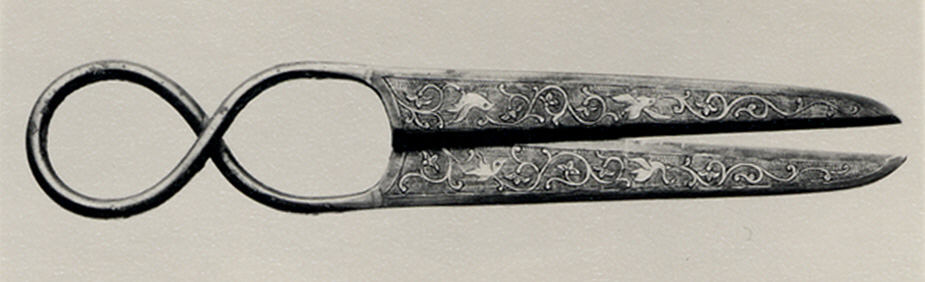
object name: scissors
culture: chinese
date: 601-900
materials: silver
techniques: gilding